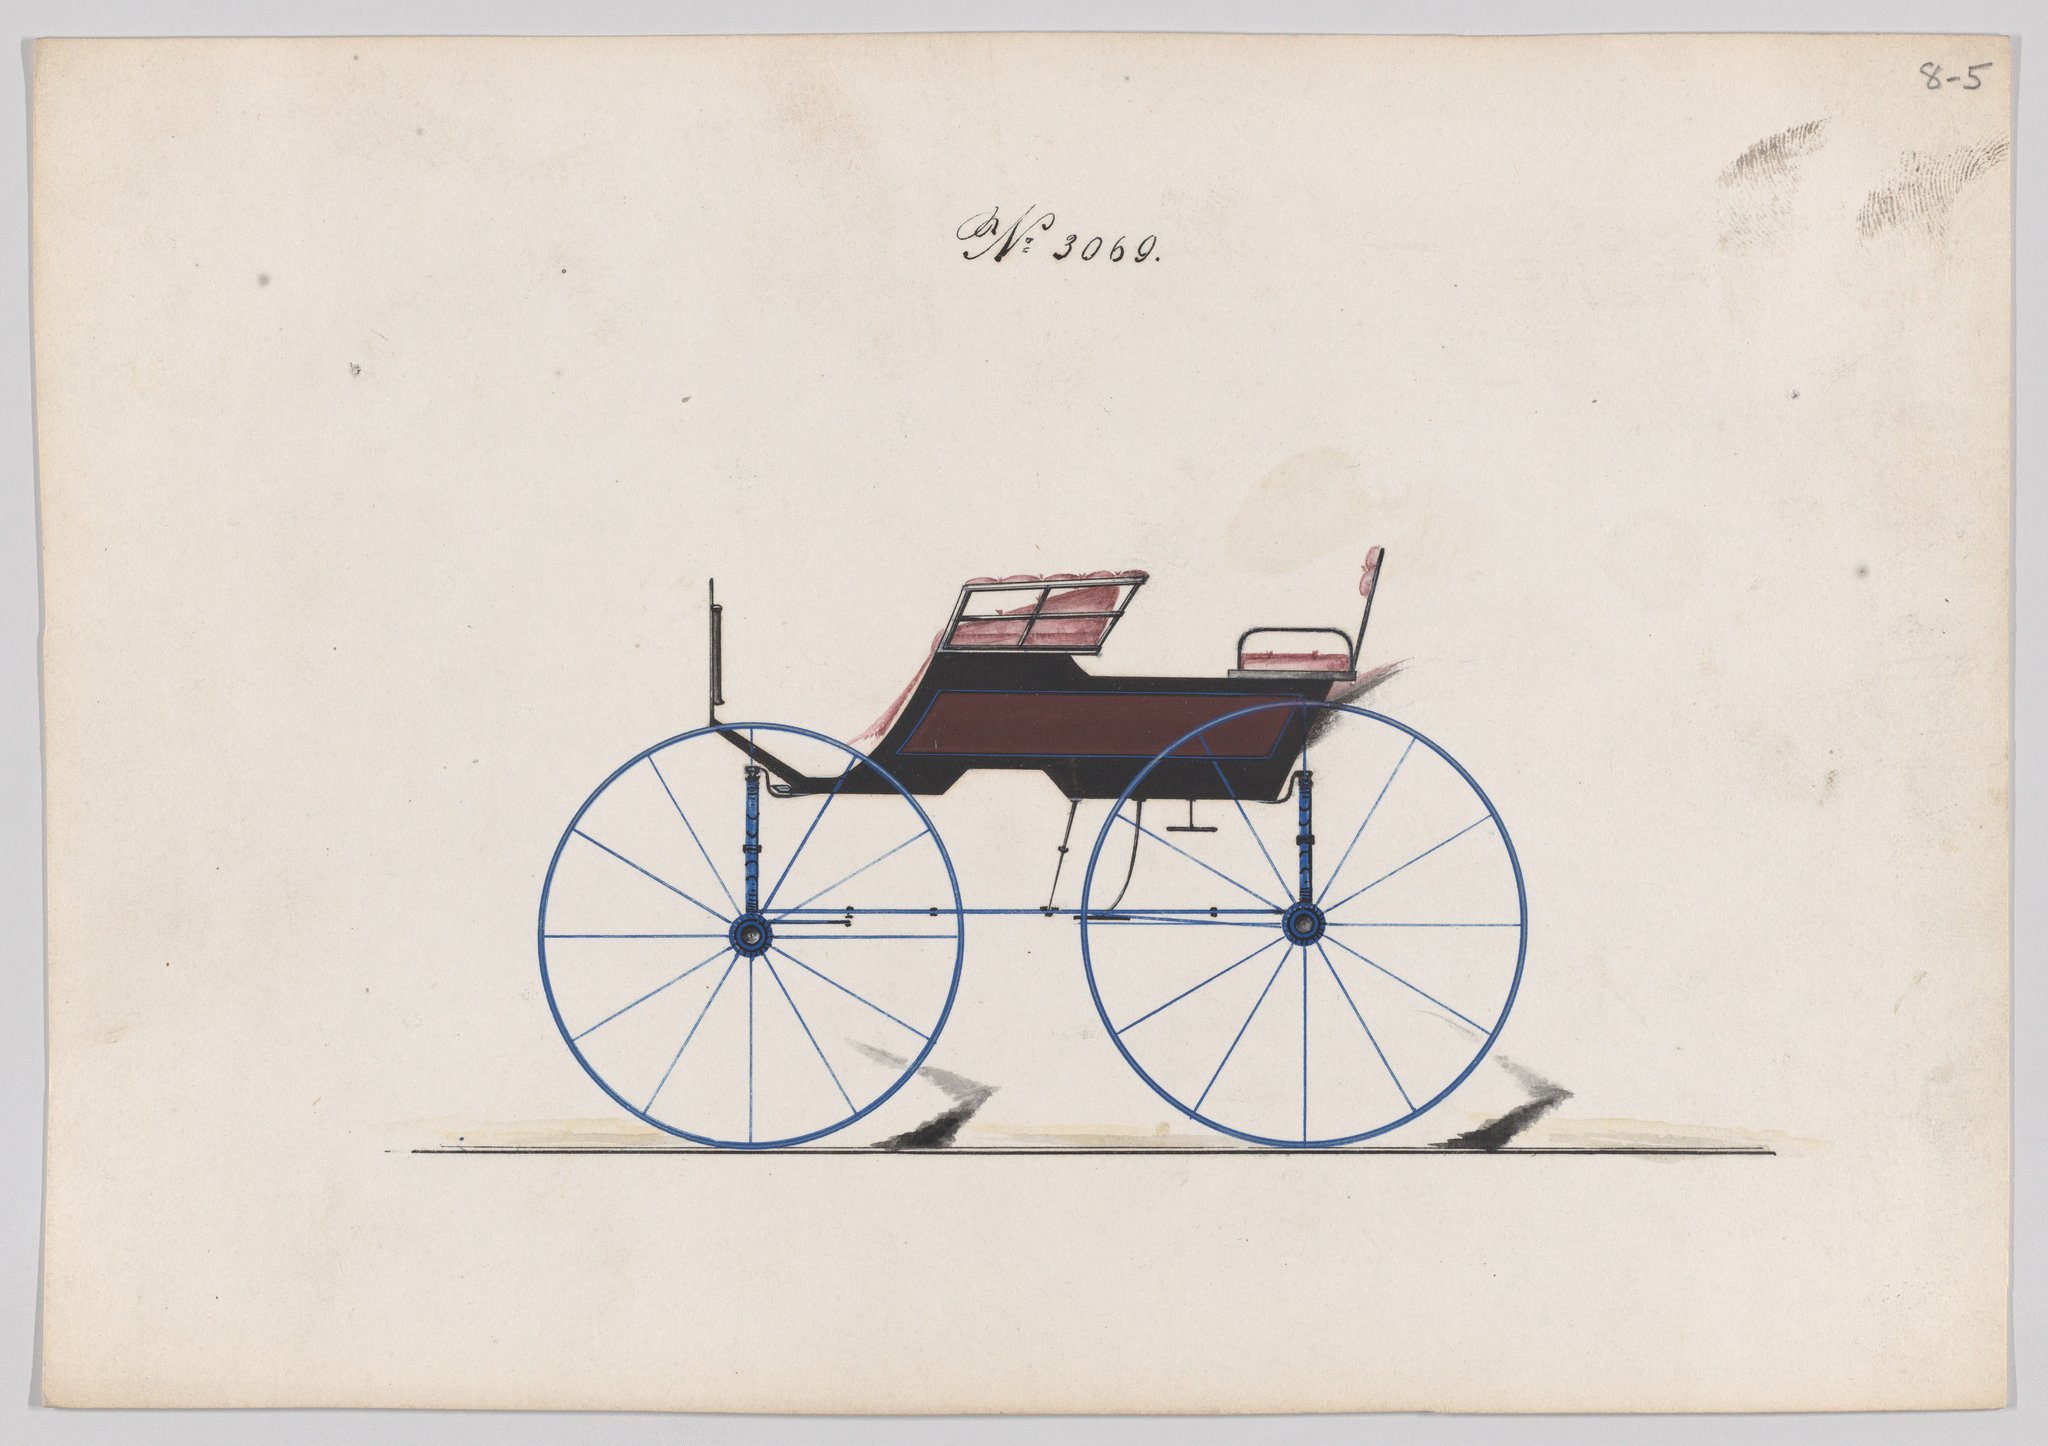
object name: drawing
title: Design for 4 seat Phaeton, no top, no. 3069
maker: brewster & co.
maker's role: manufacturer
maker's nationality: american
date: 1874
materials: gouache, ink, watercolor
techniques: pen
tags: carriages